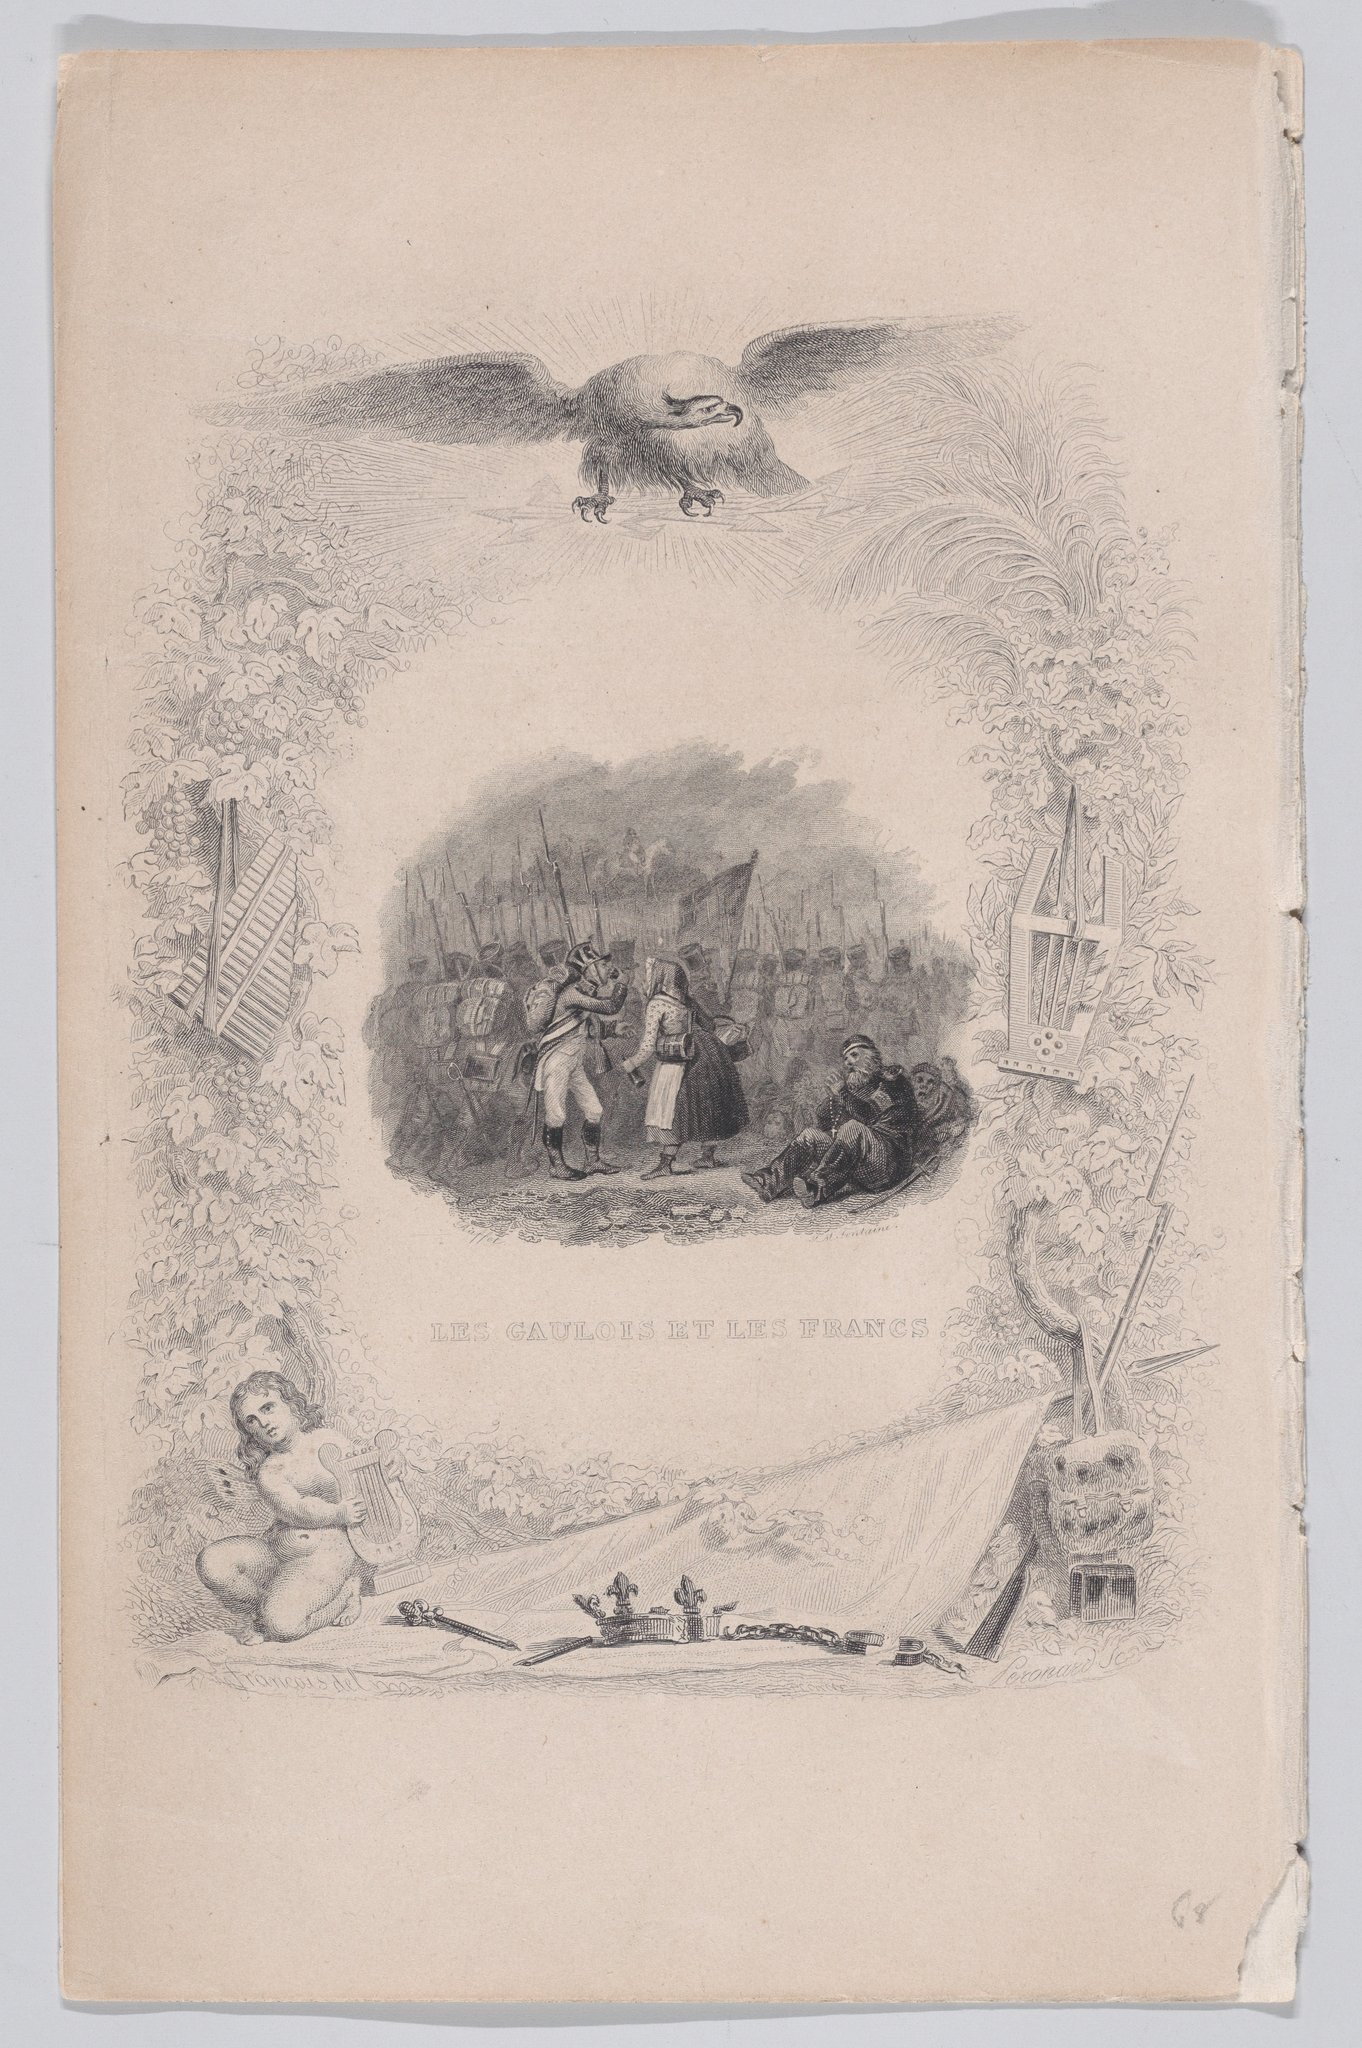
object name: print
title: The Gauls and the Francs, from "The Complete Works of Béranger"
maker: denis auguste marie raffet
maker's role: designer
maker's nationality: french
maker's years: 1804-1860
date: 1829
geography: paris